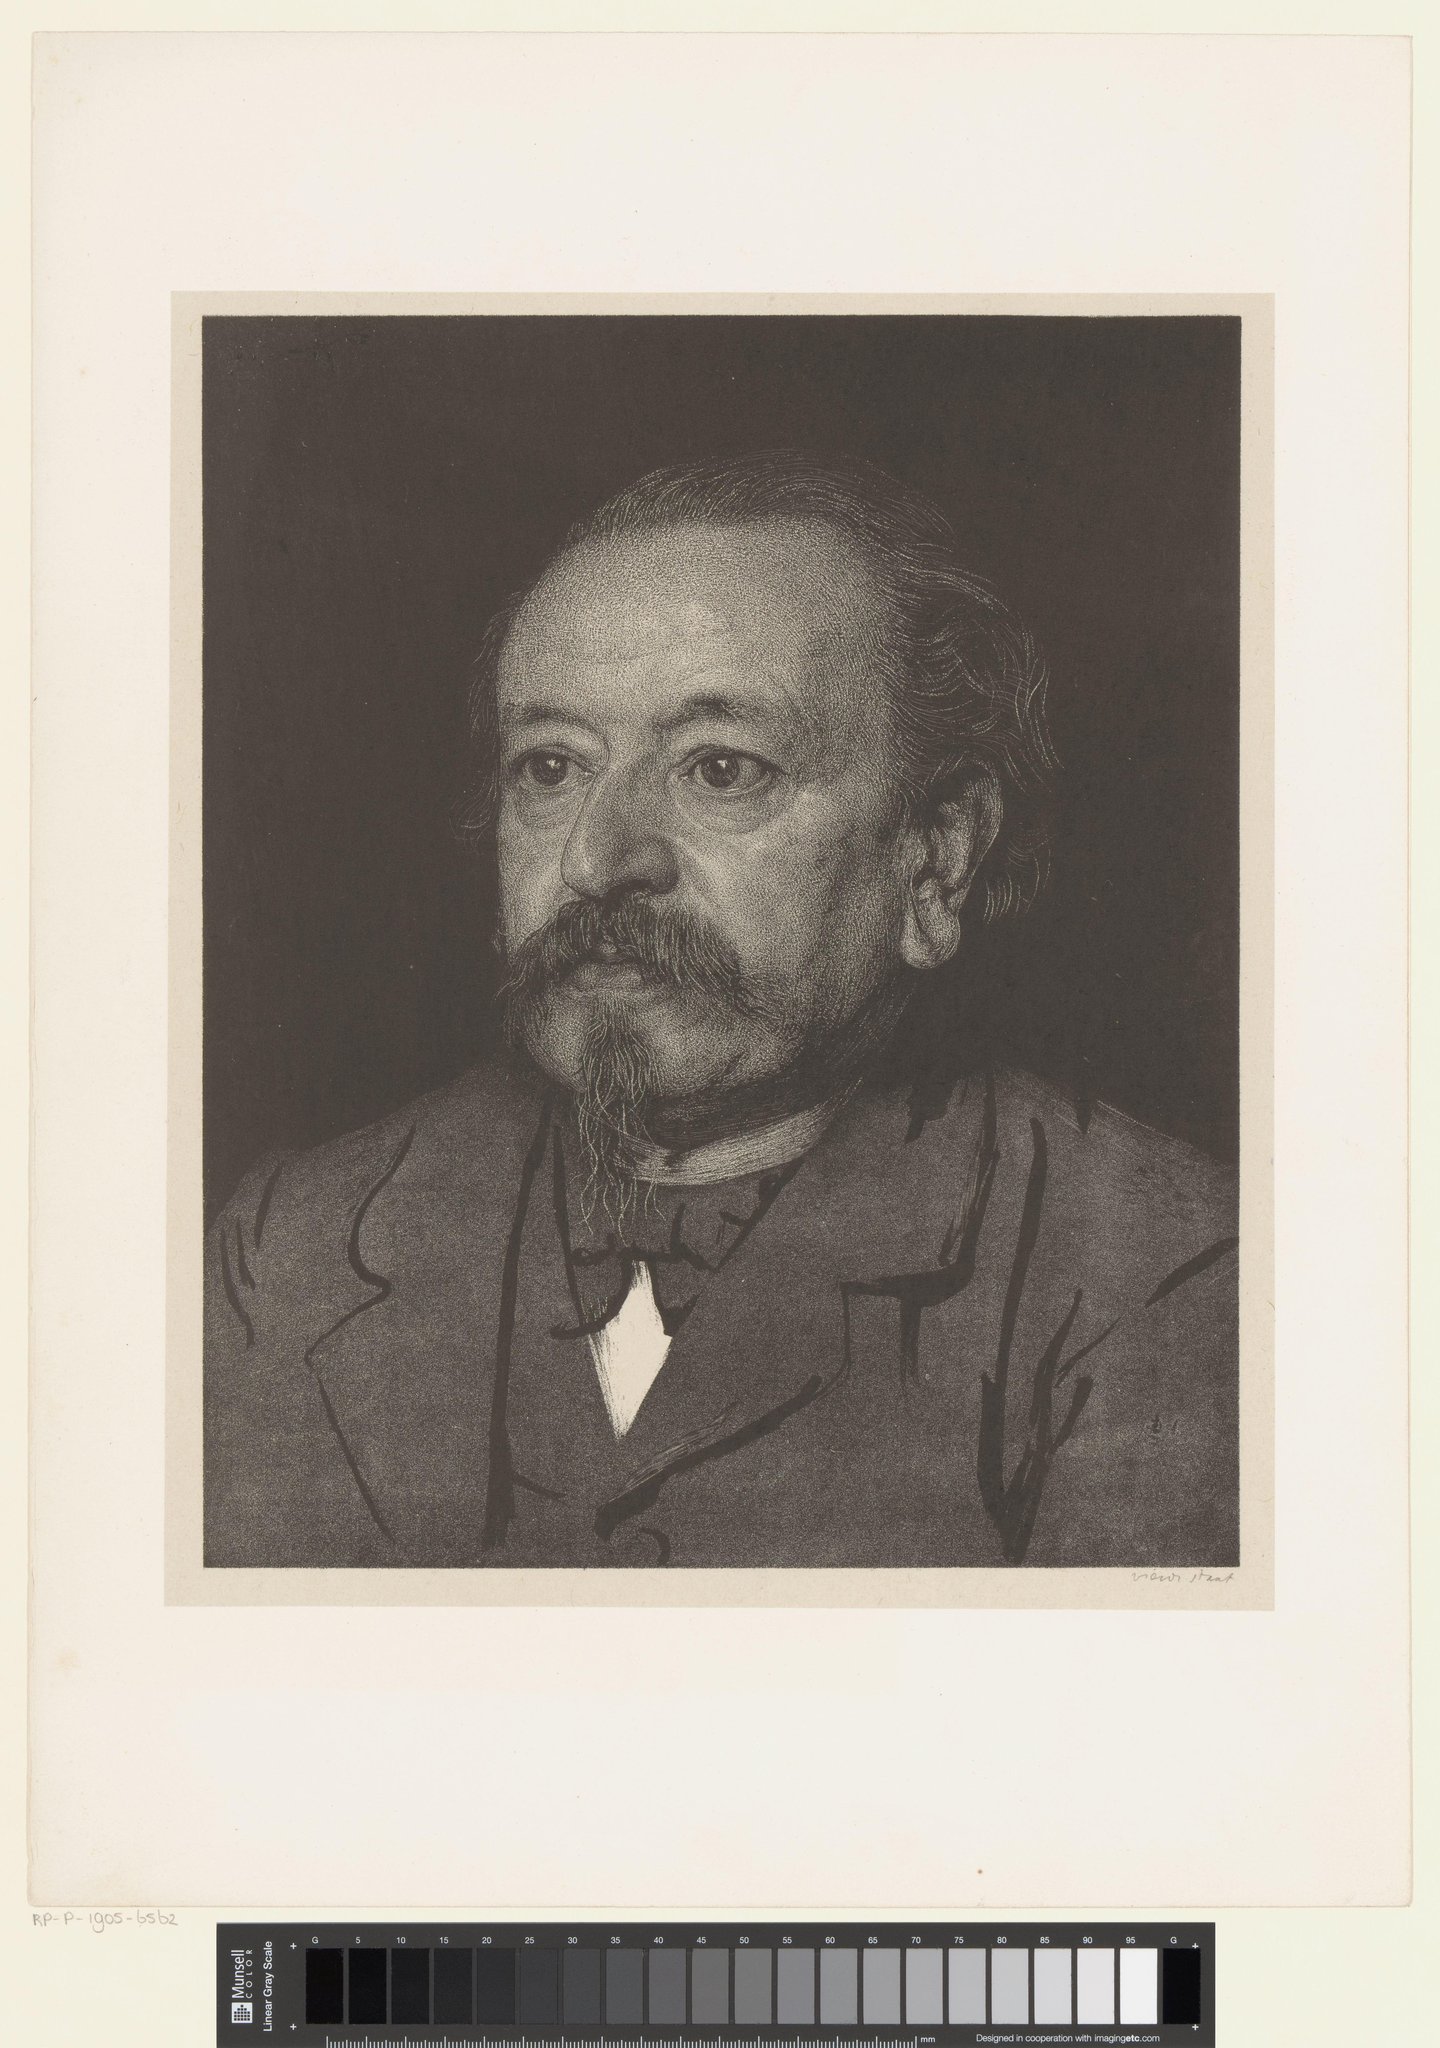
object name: print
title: Portret van Reinier Willem Petrus de Vries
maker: jan veth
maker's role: designer, draughtsman, painter, print maker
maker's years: 1864-1925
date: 1901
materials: paper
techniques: lithograph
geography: netherlands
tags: amsterdam, auctioneer, publisher, reinier willem petrus de vries (1841-1919), historical persons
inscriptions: inscription: ‘vierde staat’, collector's mark: Lugt 2228